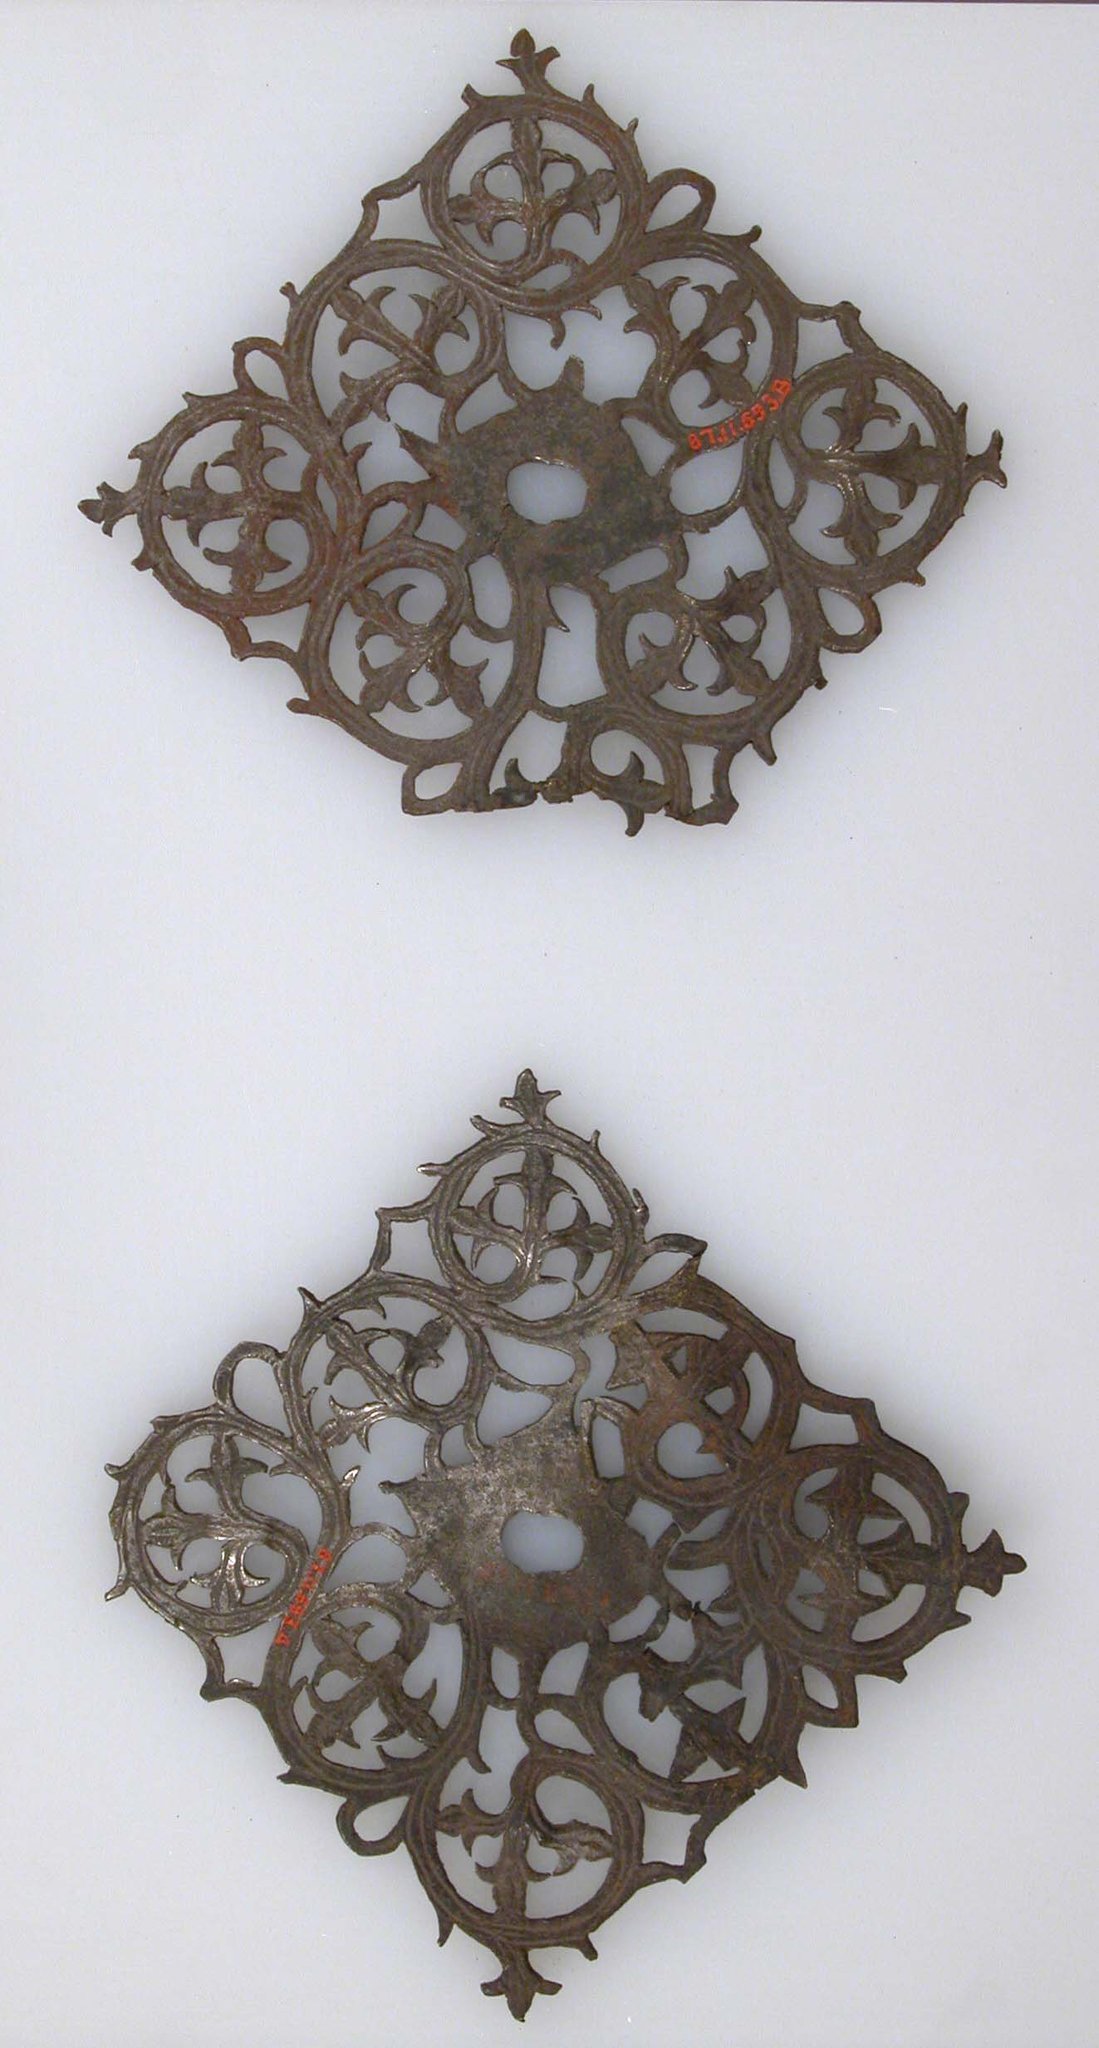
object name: plate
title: Two Plates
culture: german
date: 1467-1500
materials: iron